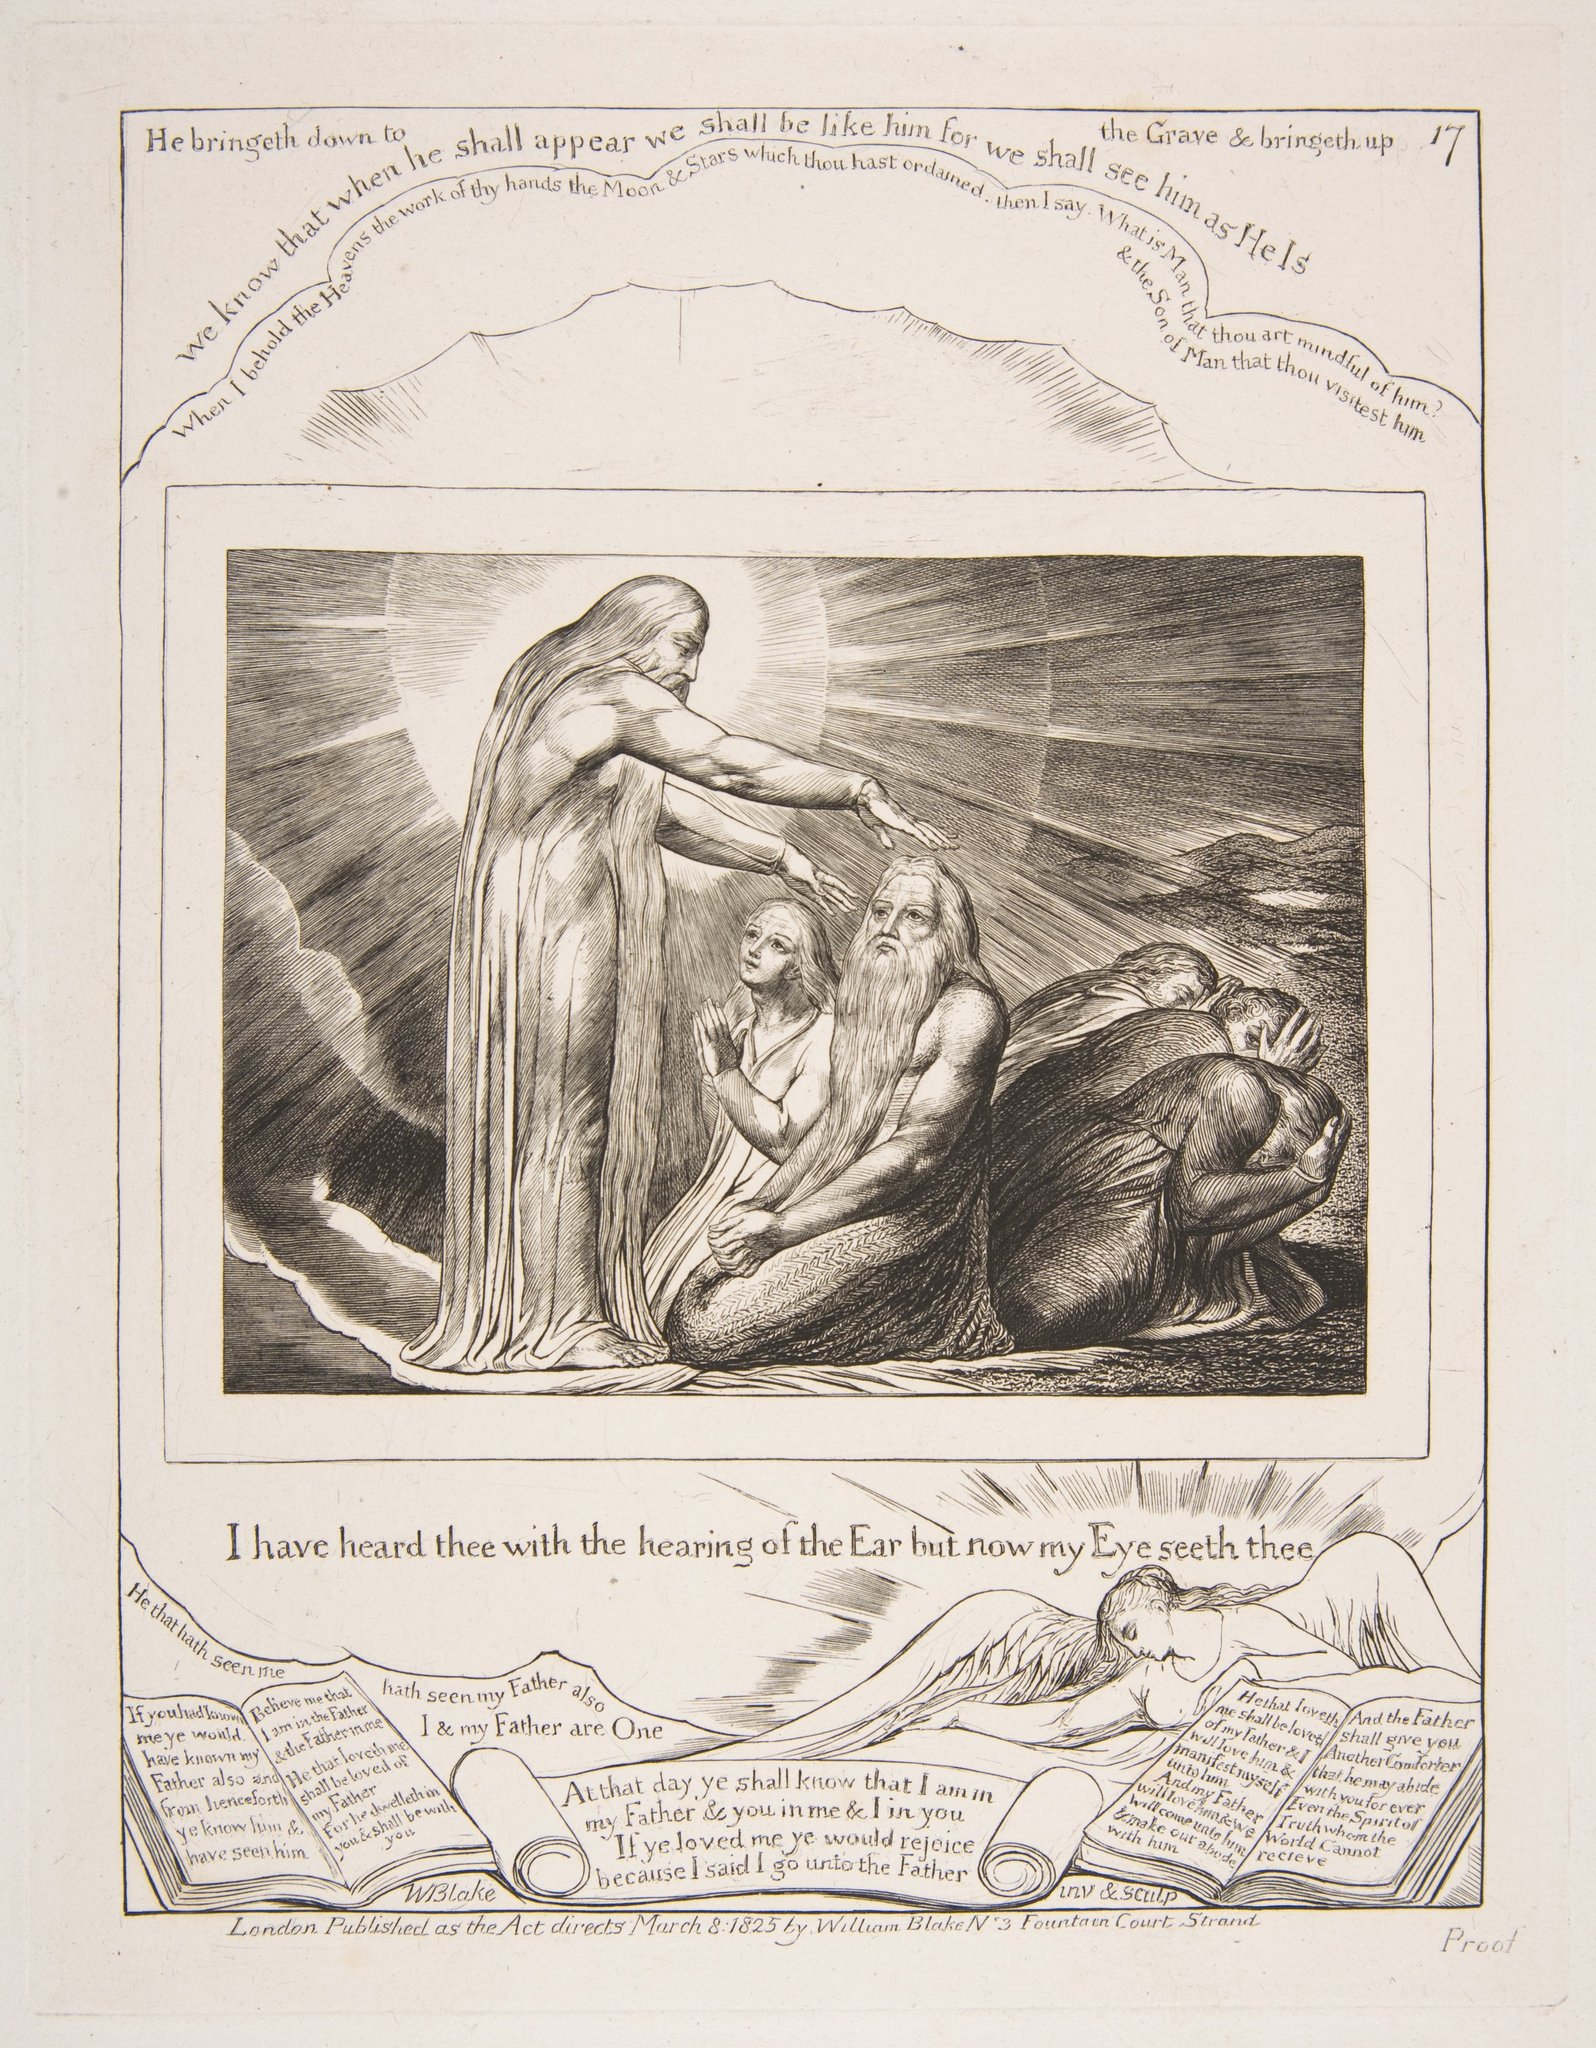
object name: print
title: The Vision of God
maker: william blake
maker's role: artist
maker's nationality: british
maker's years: 1757-1827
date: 1825-1826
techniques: engraving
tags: men,women